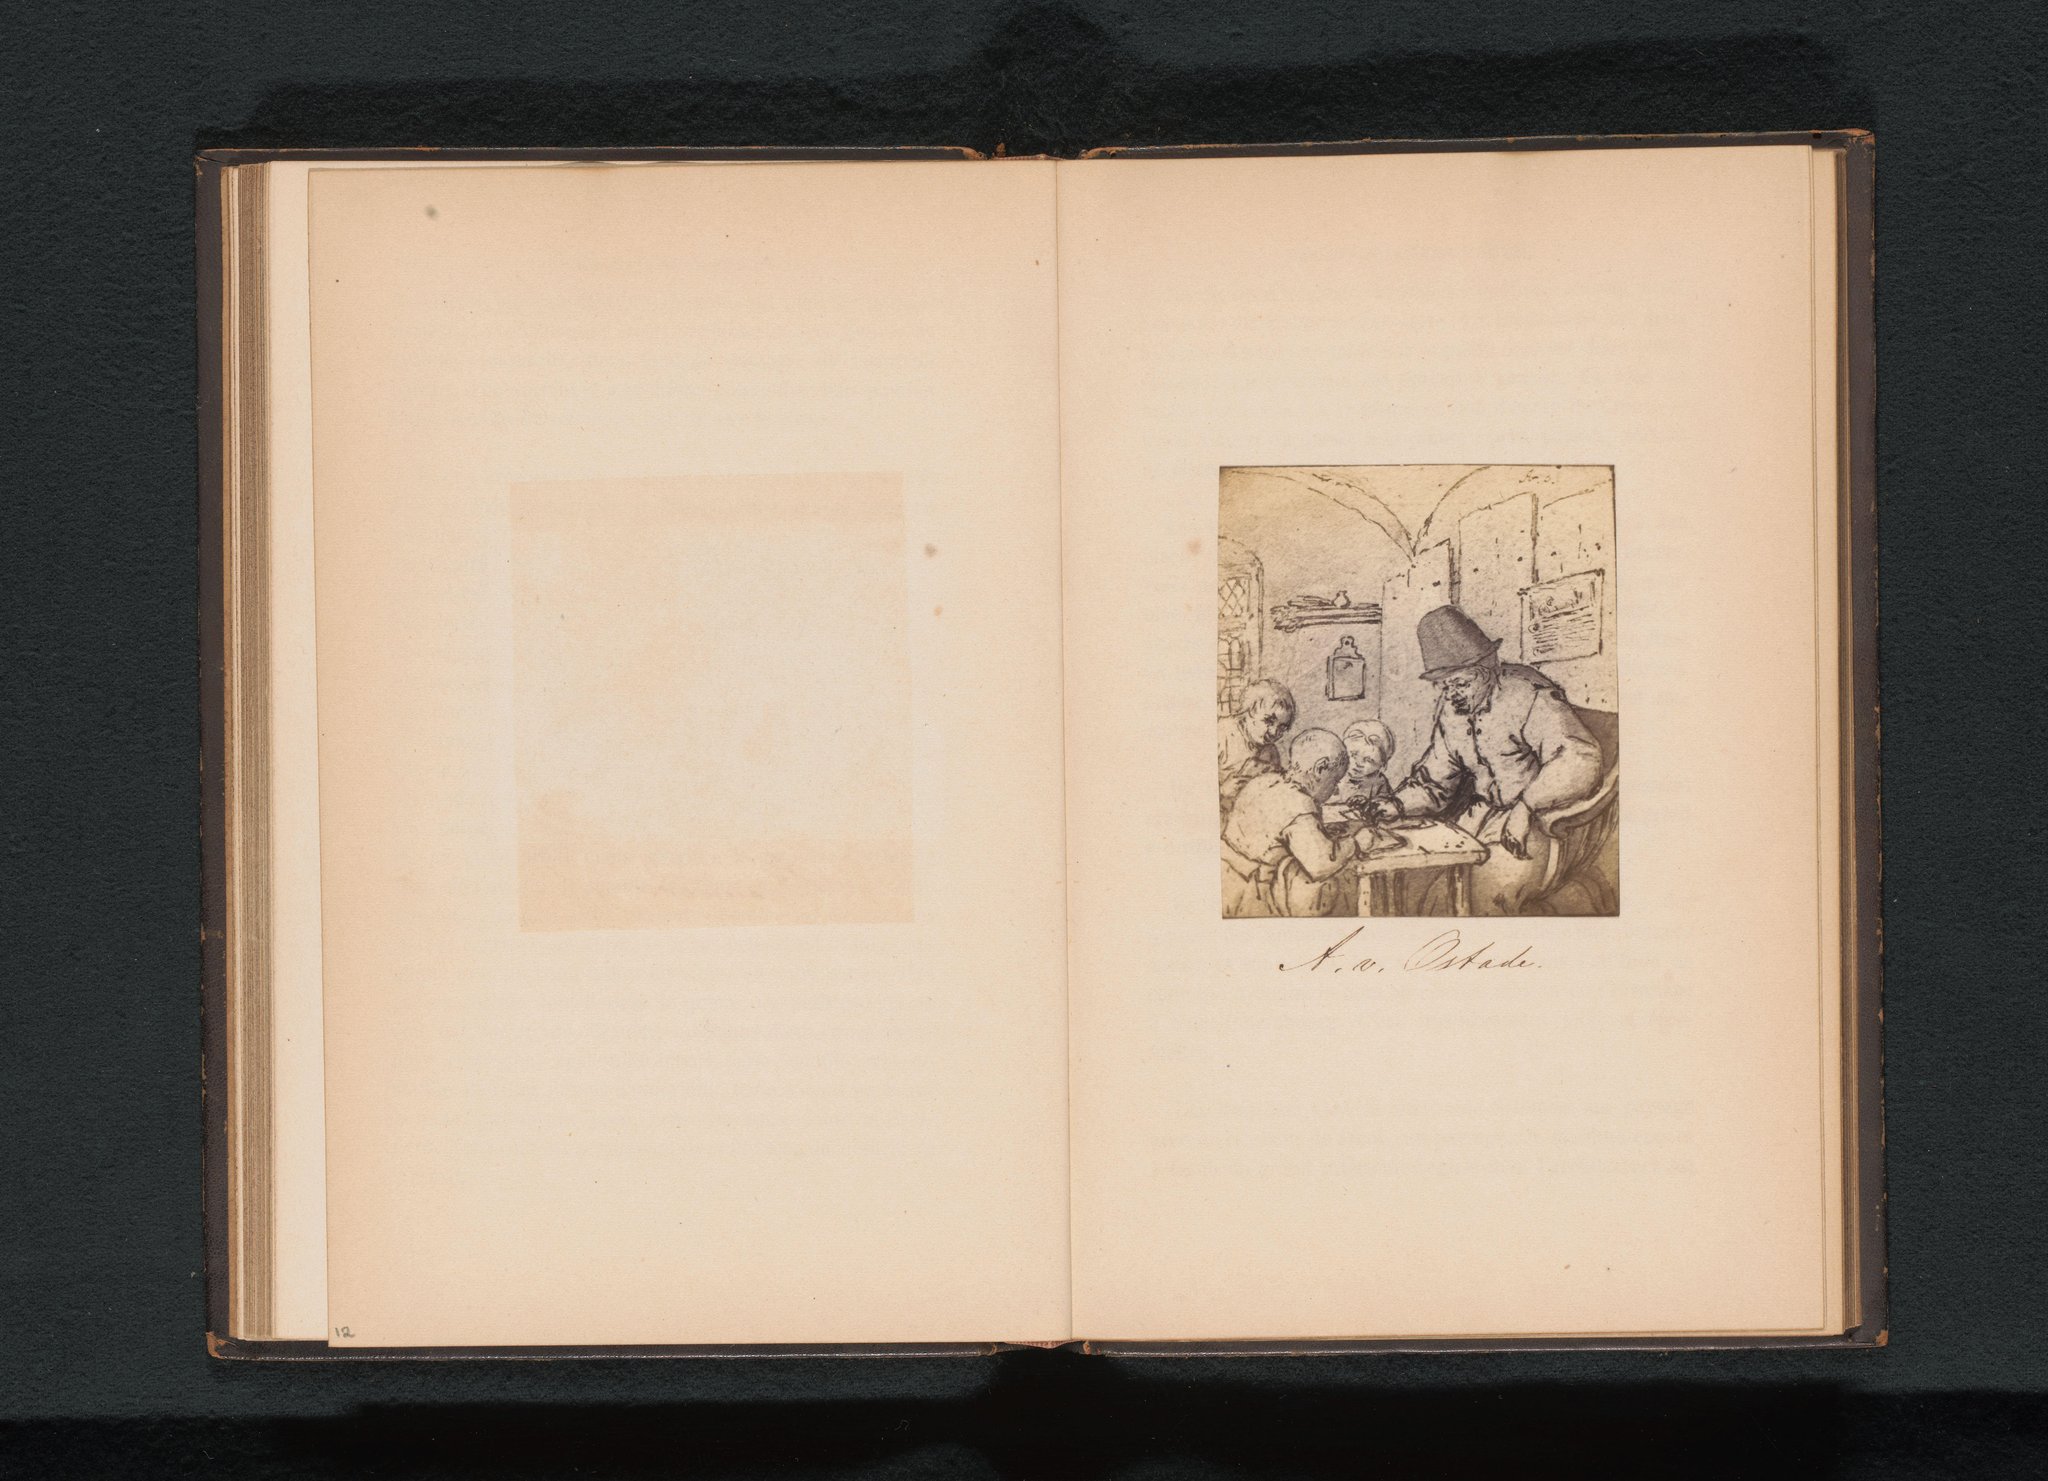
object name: reproduction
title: Fotoreproductie van een tekening van een man en drie kinderen door Adriaen van Ostade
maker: edmond fierlants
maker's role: fotograaf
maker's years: 1819-1869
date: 1855-1860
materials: photographic support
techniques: albumen print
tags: adult man, child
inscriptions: name: ‘A. v. Ostade.’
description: Foto op derde ongenummerde pagina na pagina 112.